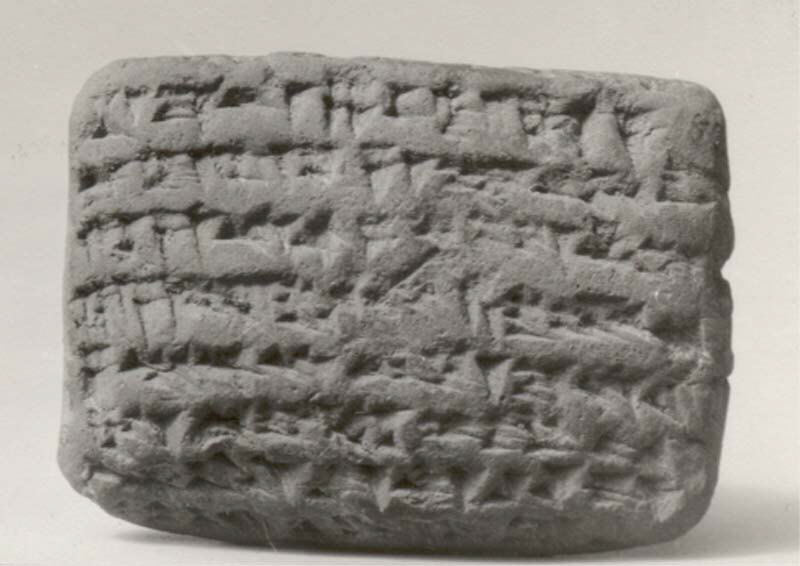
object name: cuneiform tablet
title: Cuneiform tablet: promissory note for silver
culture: babylonian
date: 540 BCE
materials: clay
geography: mesopotamia